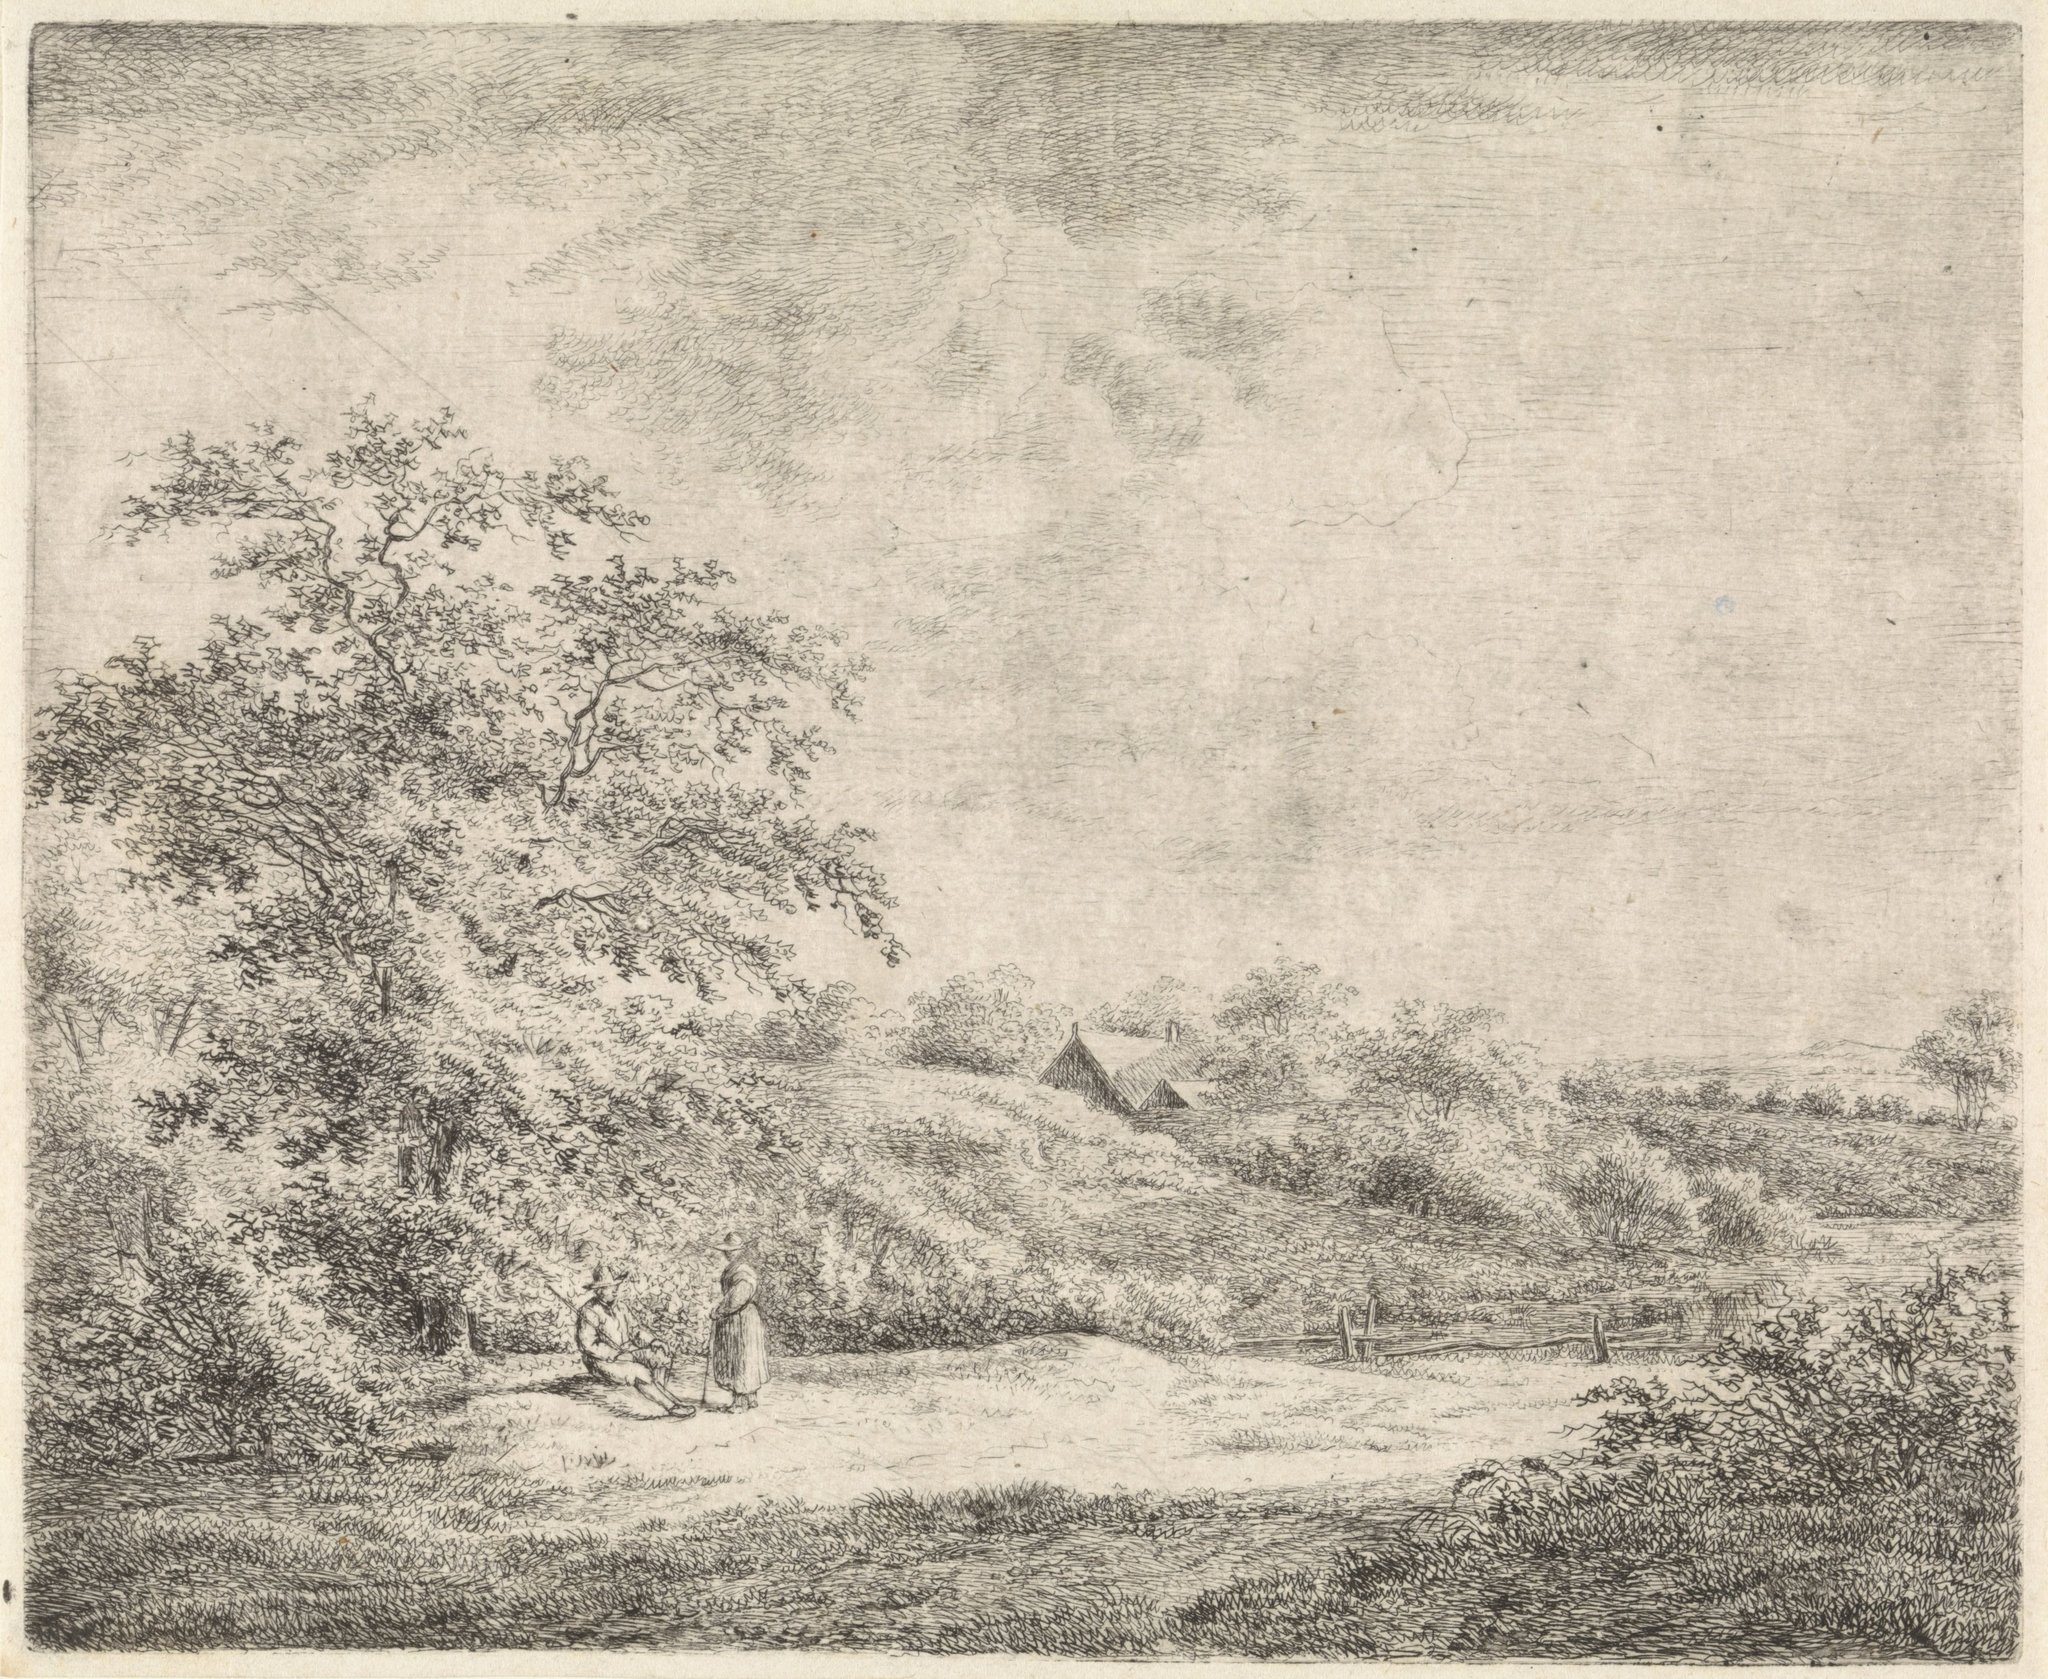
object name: print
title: Man en vrouw in heuvelachtig landschap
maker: pieter janson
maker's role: draughtsman, print maker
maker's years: 1765-1851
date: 1780-1851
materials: paper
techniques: etching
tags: landscapes (+ landscape with figures, staffage)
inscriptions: collector's mark: Lugt 2228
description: Heuvelachtig landschap met een man, zittend bij een boom, in gesprek met een vrouw. Beiden hebben een stok in hun hand.